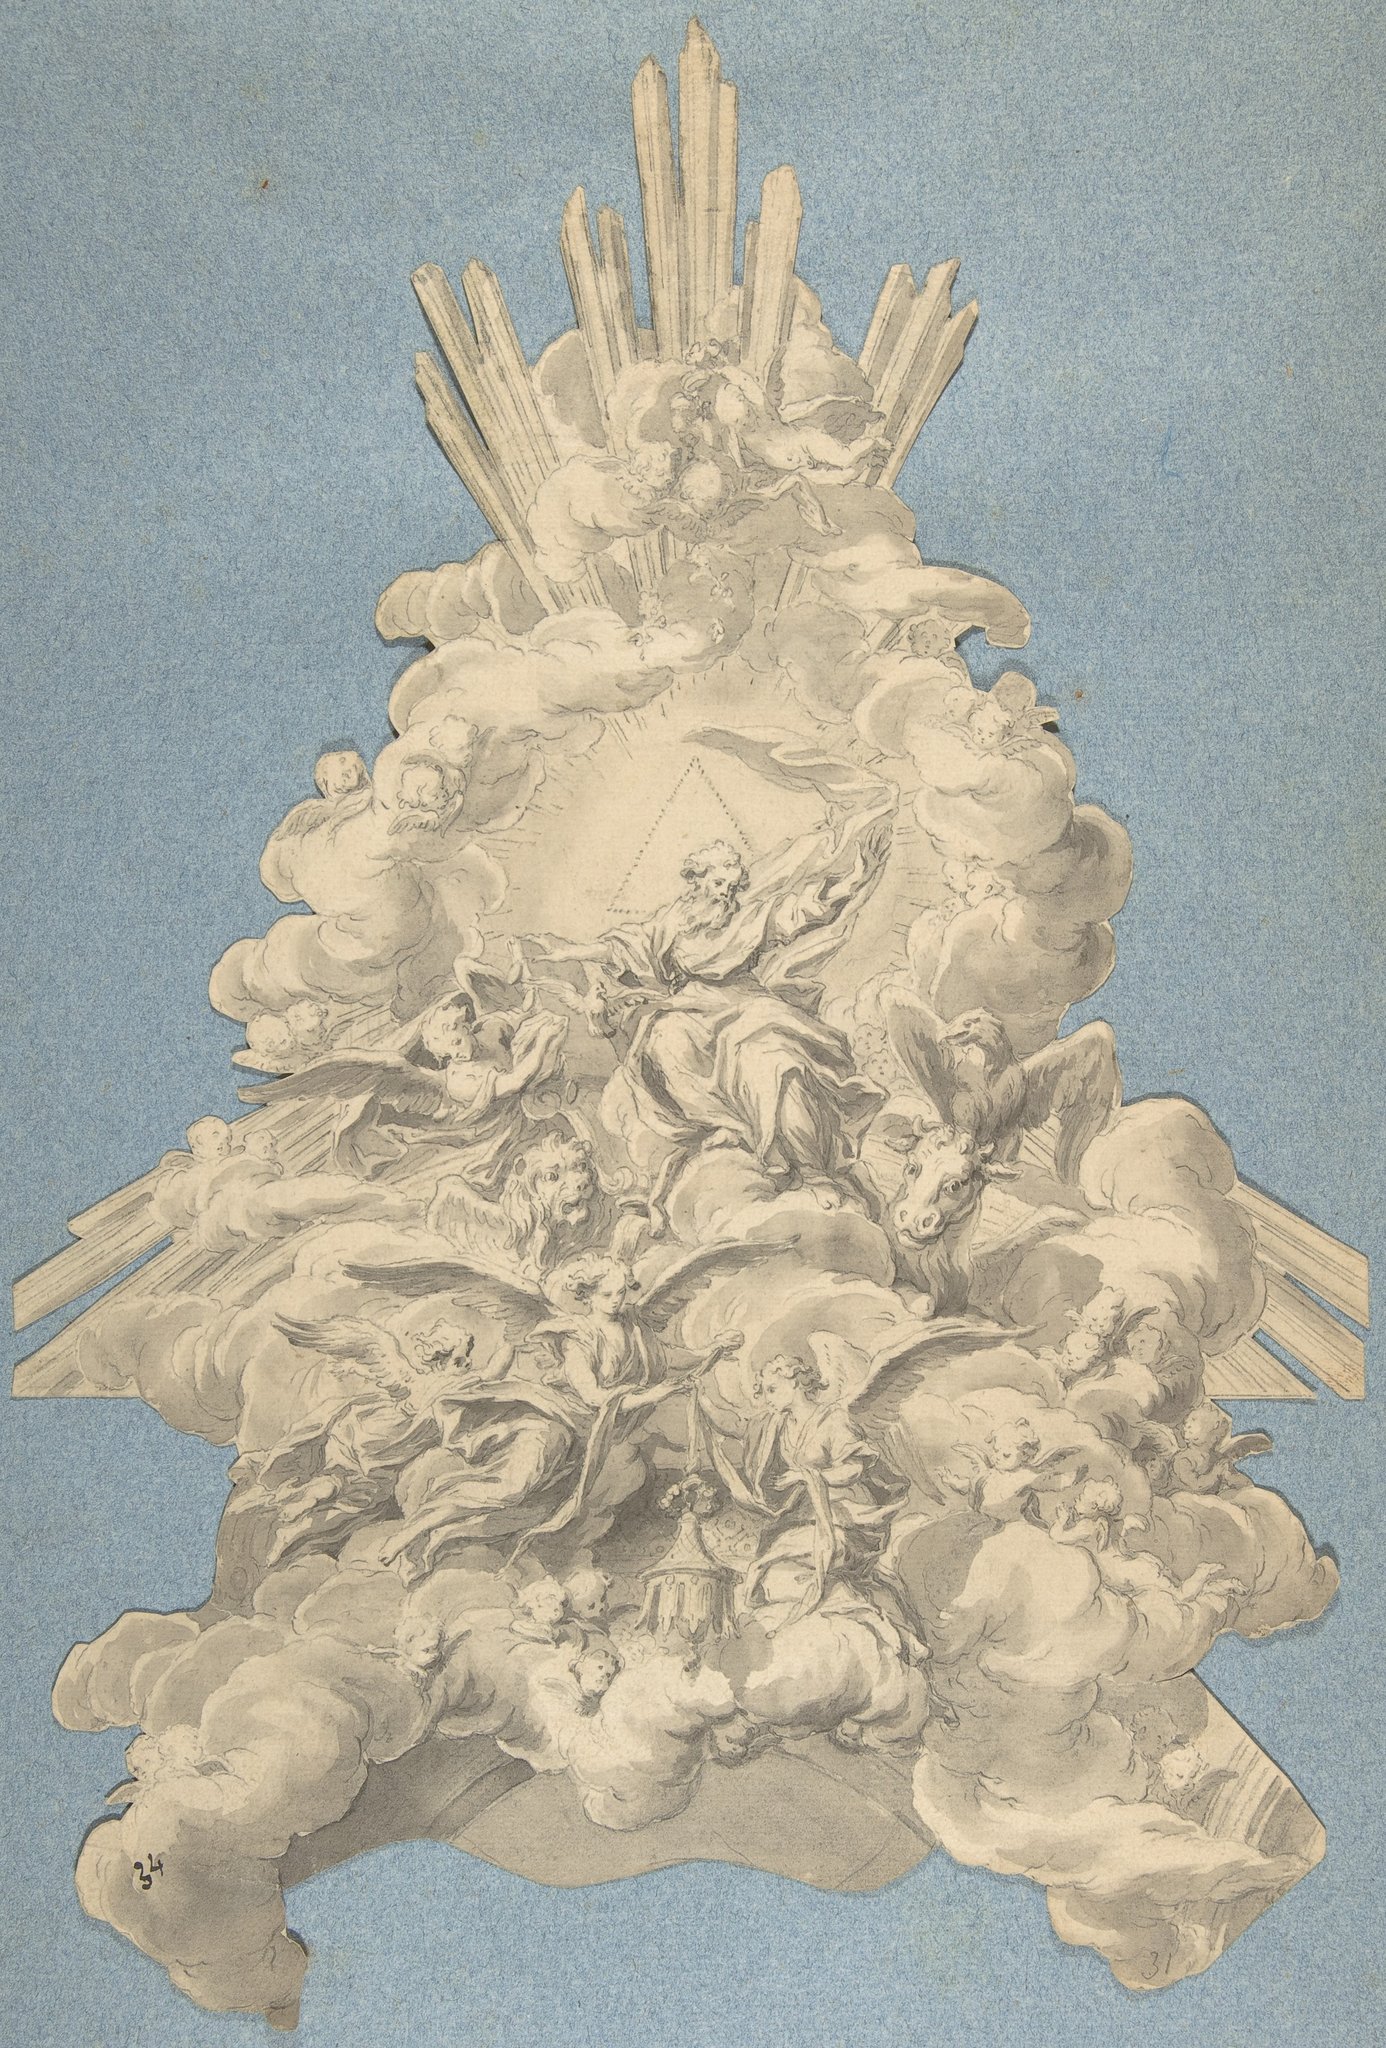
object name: drawing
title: God the Father Surrounded by Angels and the Four Animals, Symbols of the Evangelists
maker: anonymous, german, 18th century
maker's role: artist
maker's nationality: german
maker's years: 1700-1800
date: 1701-1800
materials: graphite, ink, paper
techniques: brush, cutting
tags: animals,angels,gods